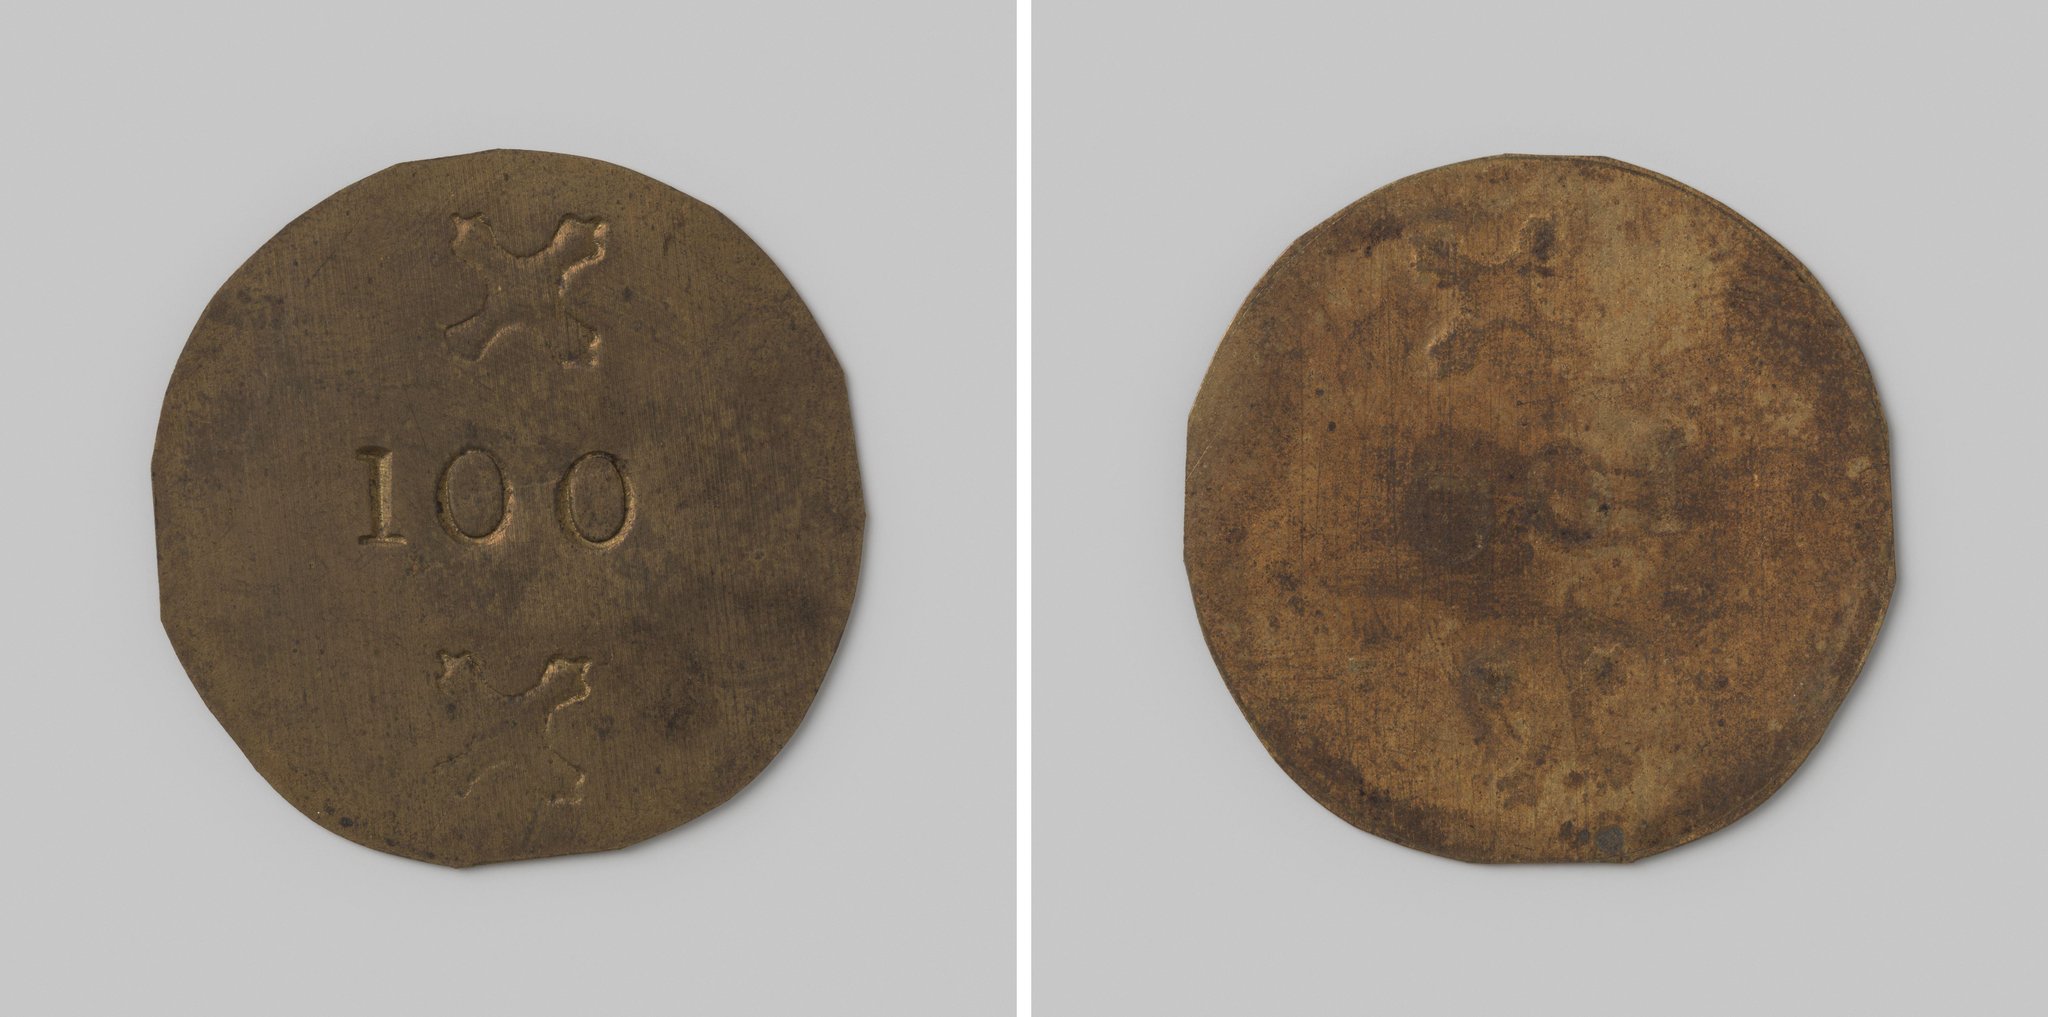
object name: monetary token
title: Betaalpenning van een gulden van de Coöperatieve Winkelvereeniging De Volharding te Veenendaal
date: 1875-1900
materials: brass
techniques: printing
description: Rond messing plaatje met instempelingen (andreaskruis) / 100 / (andreaskruis)